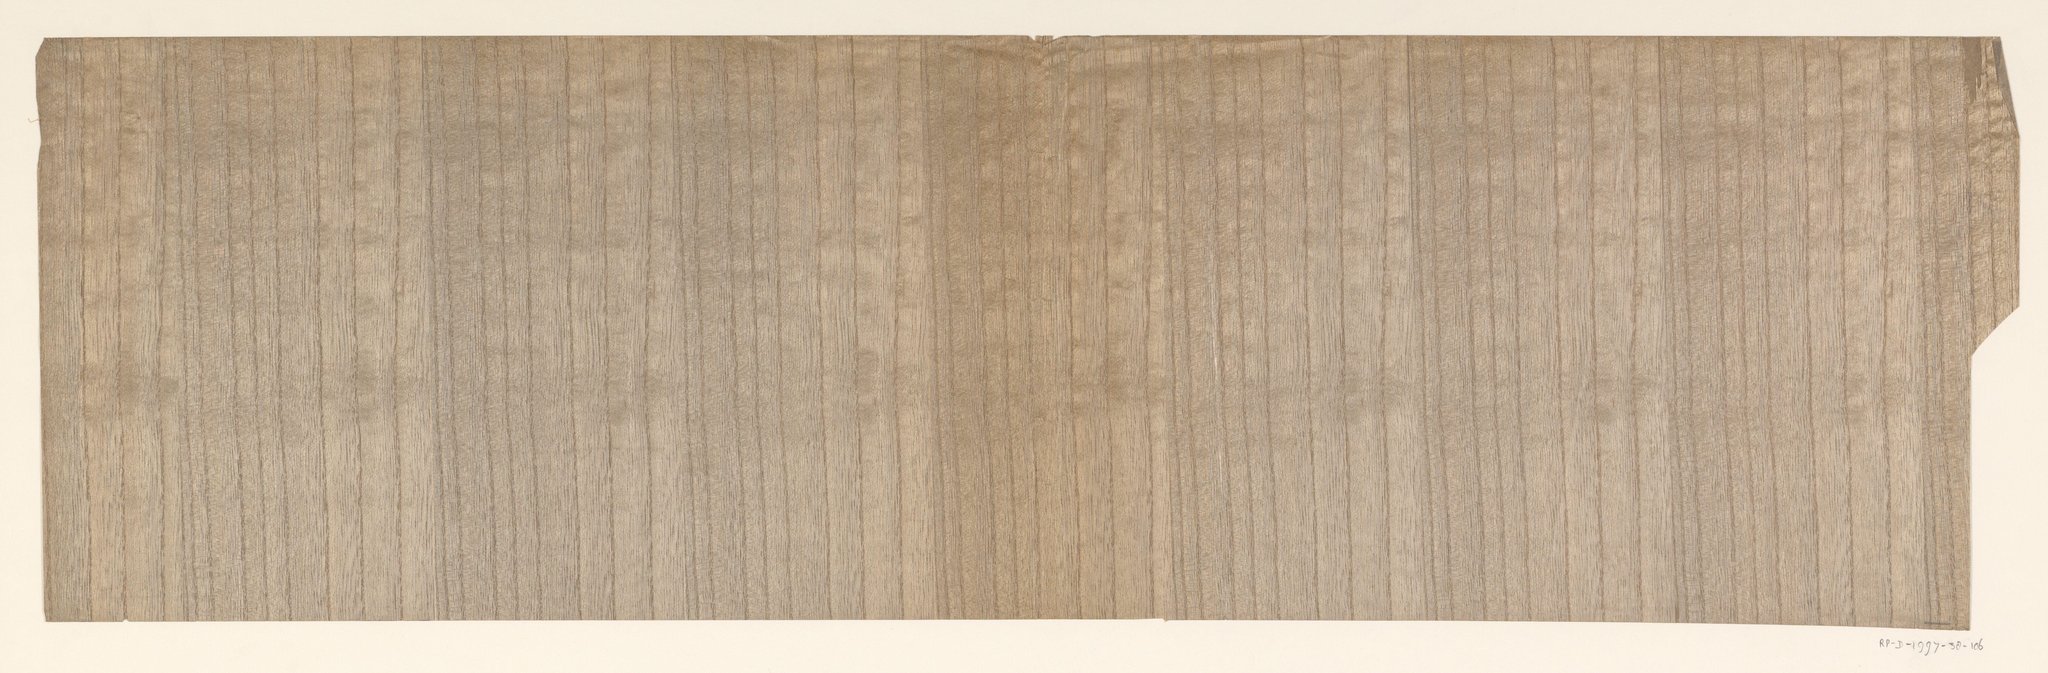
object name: paste paper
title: Stijfselverfpapier in bruin met ingedrukte houtstructuur imiterende decoratie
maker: Anonymous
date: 1900-1970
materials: lacquer, paper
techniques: lacquer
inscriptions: collector's mark: Lugt 2228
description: Stijfselverfpapier in bruin met verticale banen met een herhaalde ingedrukte houtstructuur imiterende decoratie.